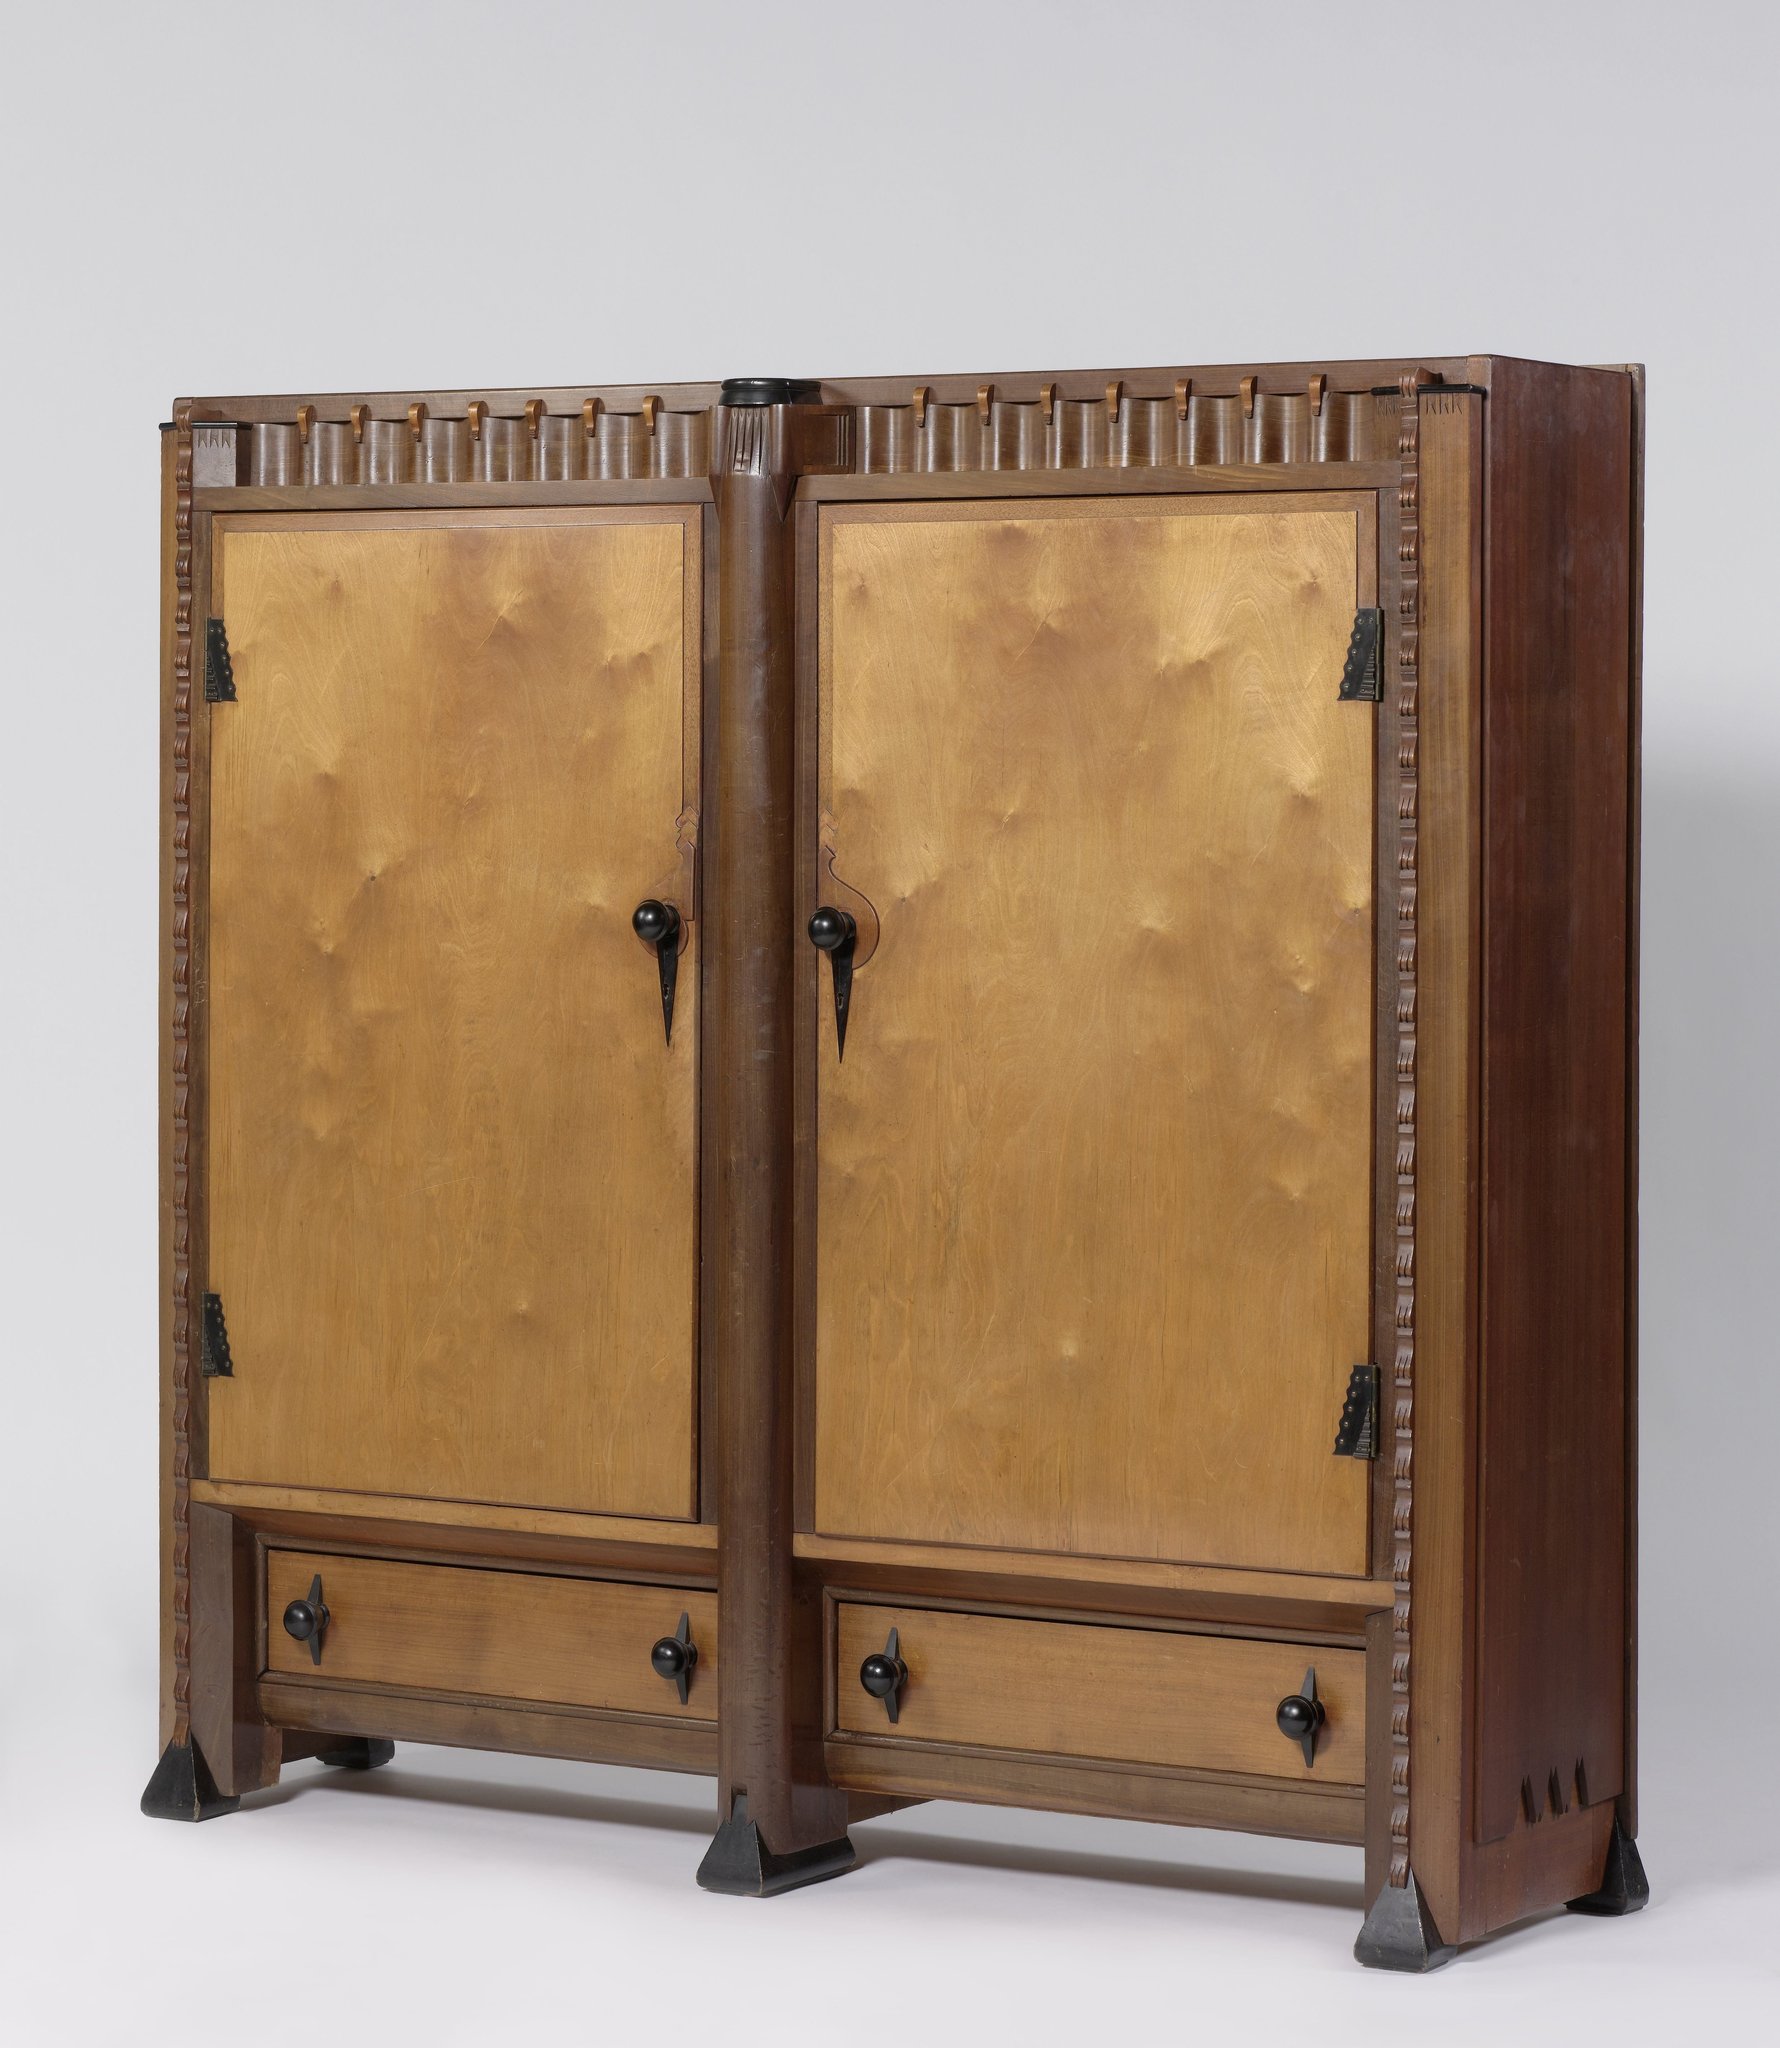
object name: case furniture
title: Kast met twee deuren en daaronder laden met een grillig gebeeldhouwd ornament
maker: michel de klerk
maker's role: painter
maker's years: 1884-1923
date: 1911-1920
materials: wood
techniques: staining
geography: amsterdam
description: Kast van triplex, berken- en populierenhout rustend op brede voeten die doorlopen in drie stijlen. De brede kast heeft twee deuren met daaronder twee laden die iets terugwijken. In het midden bevindt zich een brede ronde middenstijl. De twee hoekstijlen bevatten een grillig gebeeldhouwd gekarteld motief. De golvende lijst aan de bovenzijde van de kast wijkt terug en bevat gebeeldhouwde elementen. De middenstijl is aan de bovenzijde verbonden met de lijst door middel van schuinstaande schotten die aan de voorzijde uitlopen in een spitse V-vorm. Zowel op de laden als op de deuren bevinden zich grote ronde zwart geverfde knoppen. De deuren bevatten sleutelplaten in een spitse V-vorm en scharnieren in met een schuine gekartelde zijde.